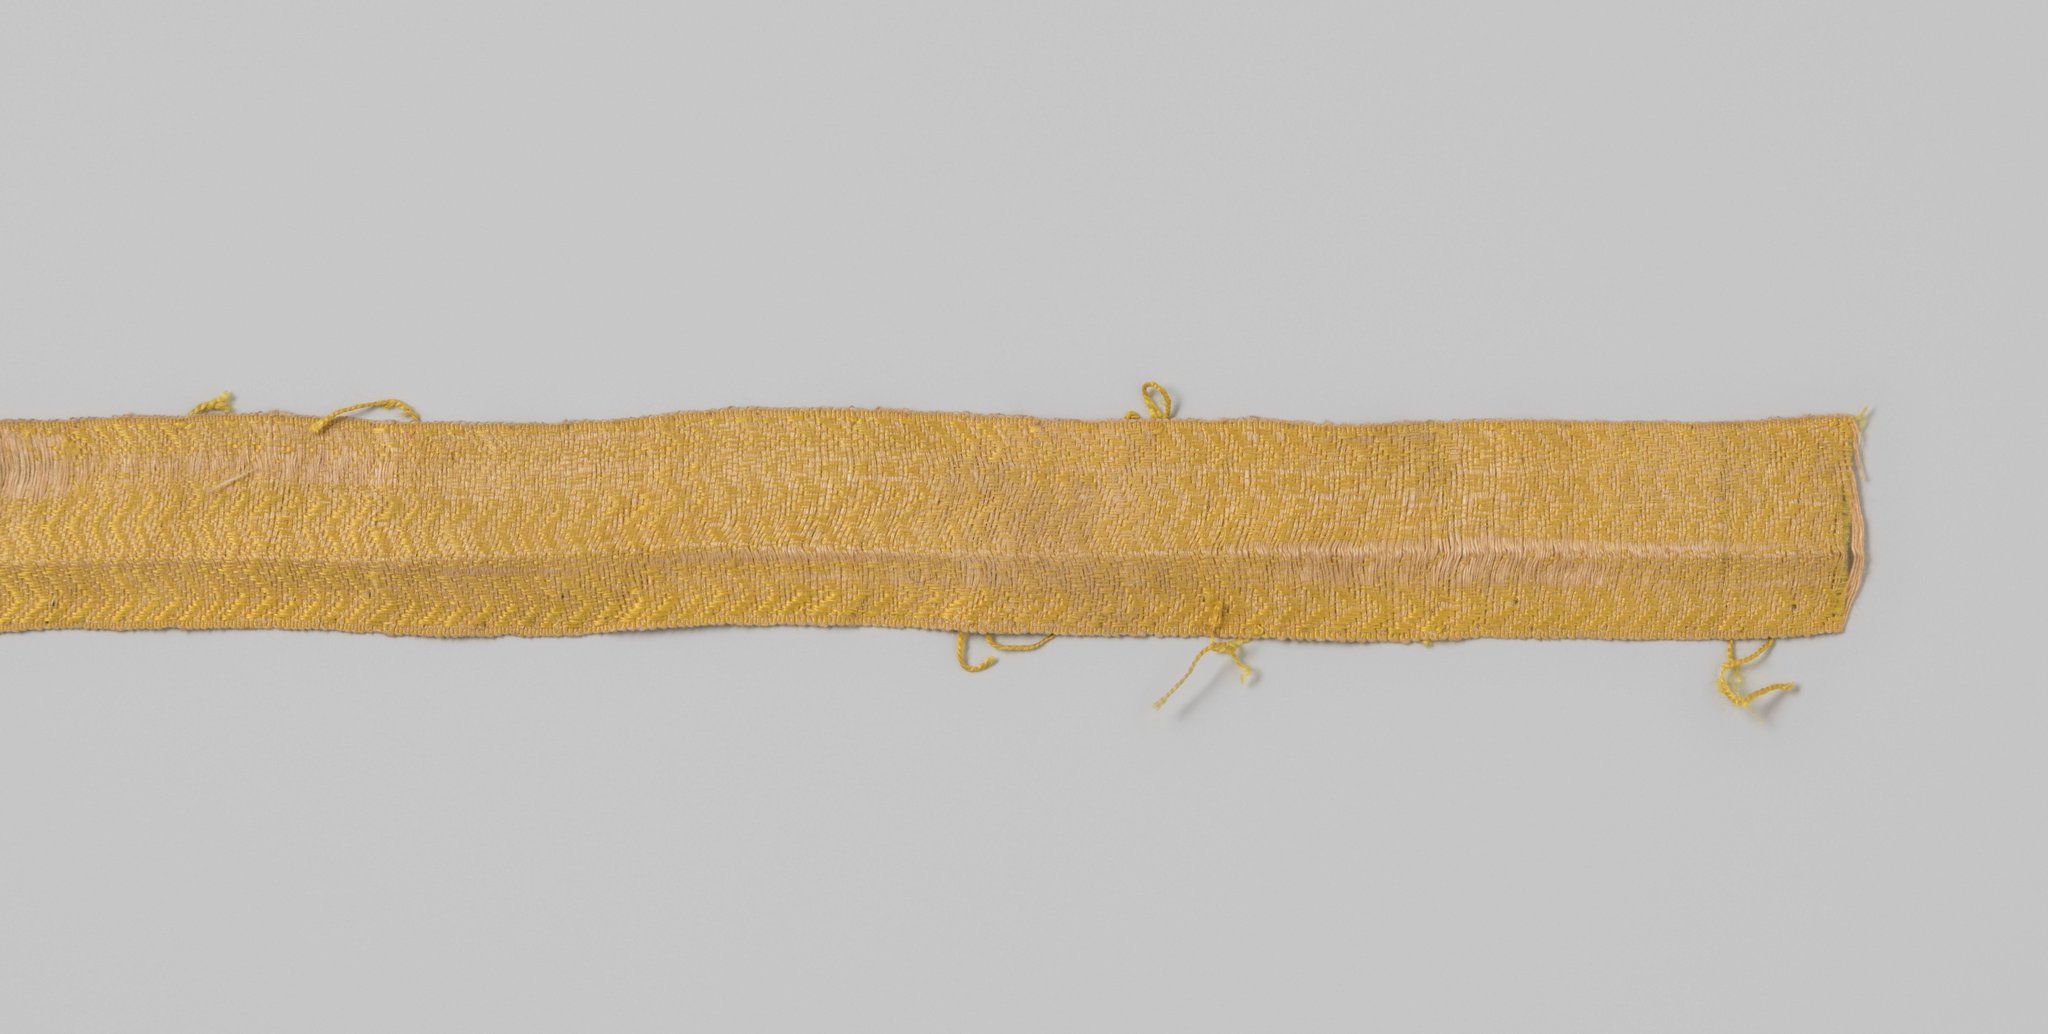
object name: braid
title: Passement van linnen en gele zijde in zigzagpatroon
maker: Anonymous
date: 1700-1899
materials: linen, silk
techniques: weave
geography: europe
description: Passement van linnen en gele zijde in een patroon van evenwijdige lijnen in een zigzagpatroon. Object overeenkomstig met BK-NM-12186-23.